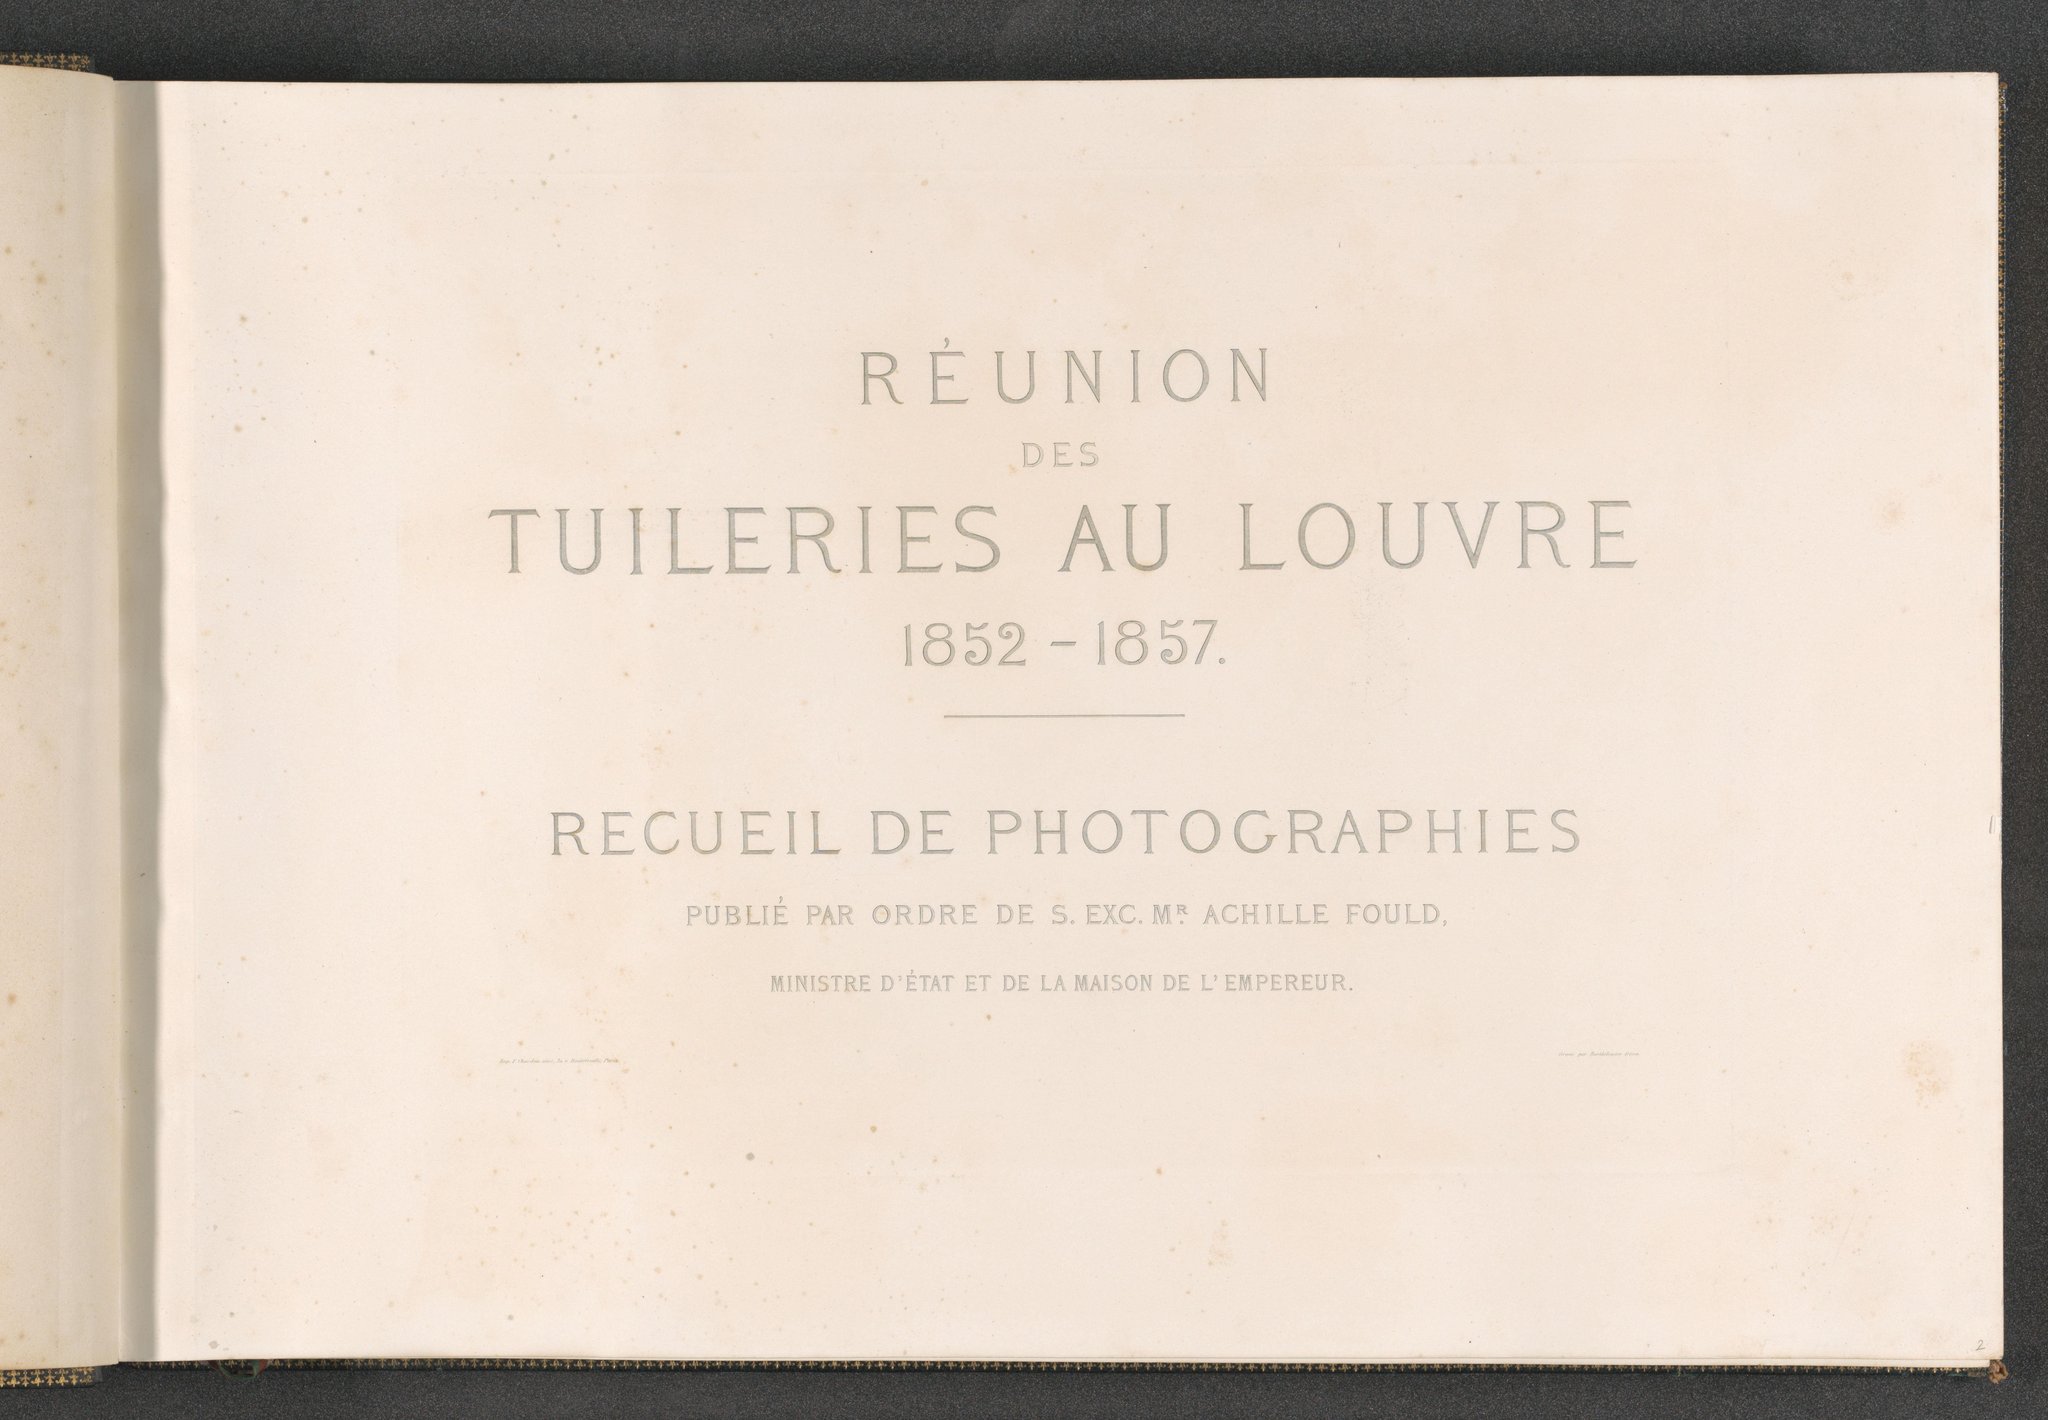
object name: album leaf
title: Titelpagina van Réunion des Tuileries au Louvre 1852-1857, album 2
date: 1857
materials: paper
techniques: engraving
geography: paris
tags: permanent exhibition, museum, paris, tuileries palace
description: Onderdeel van Réunion des Tuileries au Louvre 1852-1857, album 2.